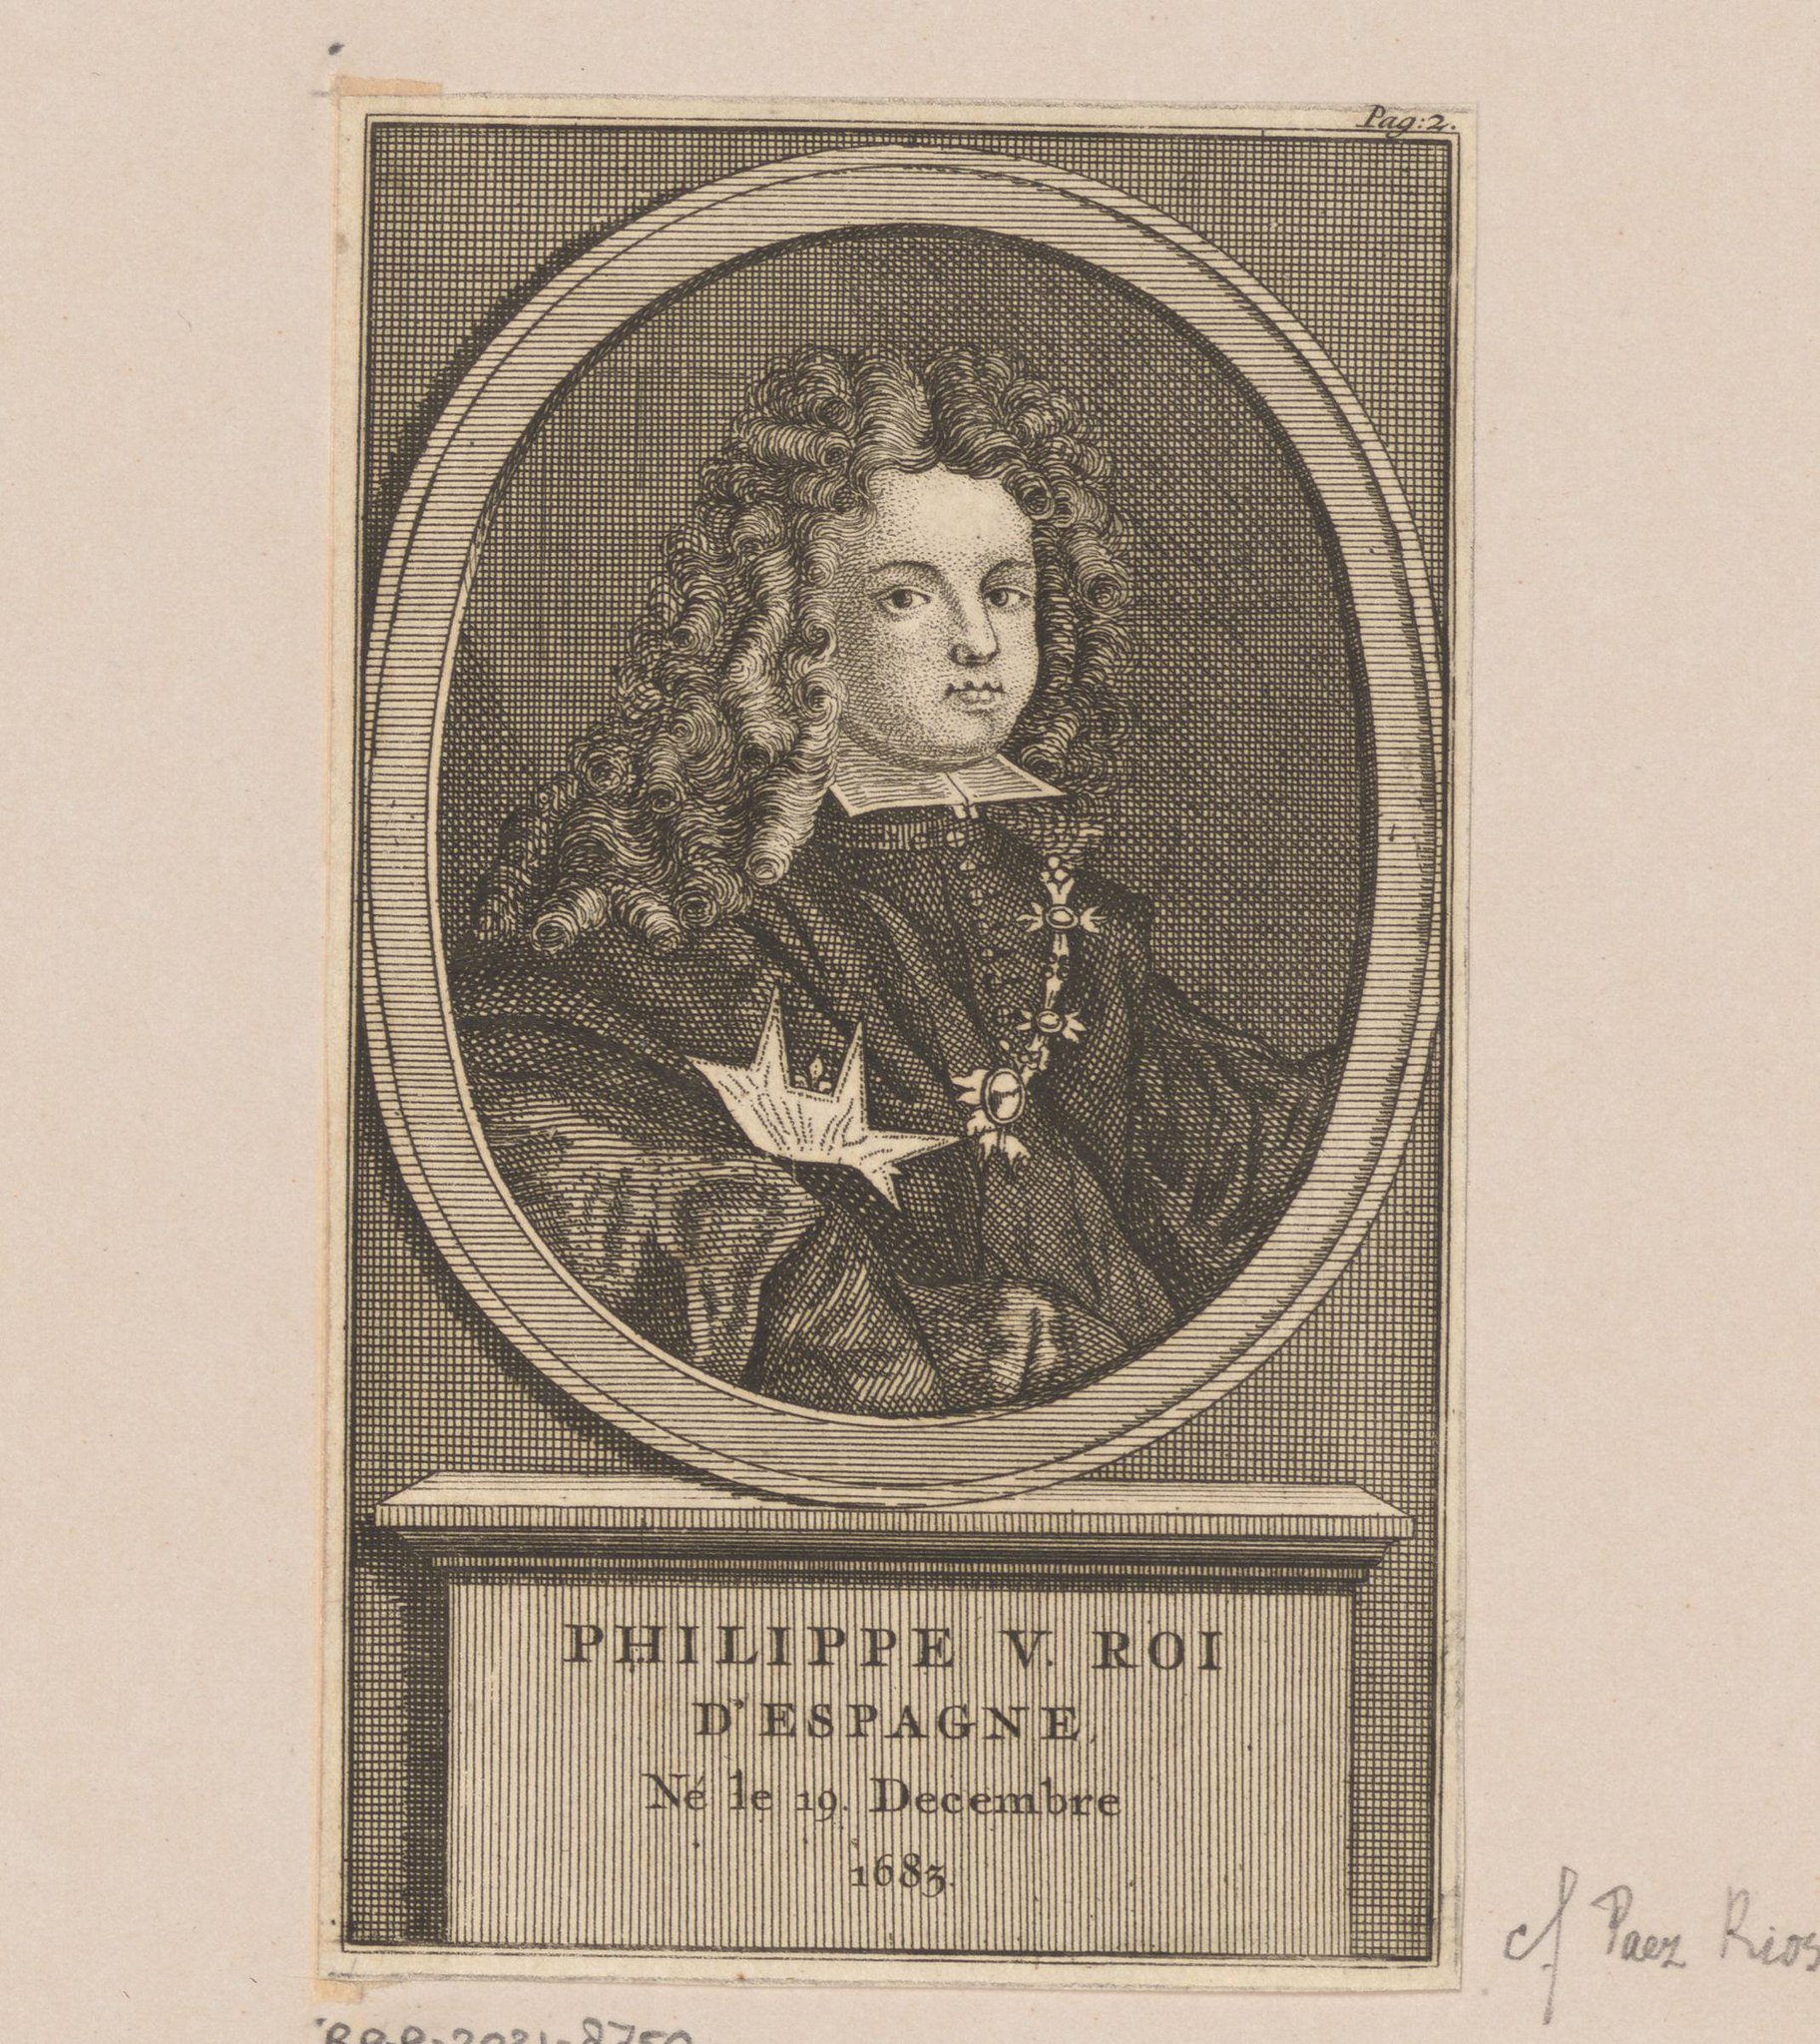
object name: print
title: Portret van Filips V, koning van Spanje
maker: Anonymous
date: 1700-1799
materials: paper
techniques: engraving, etching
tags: filips v (koning van spanje), historical persons, youth, adolescent